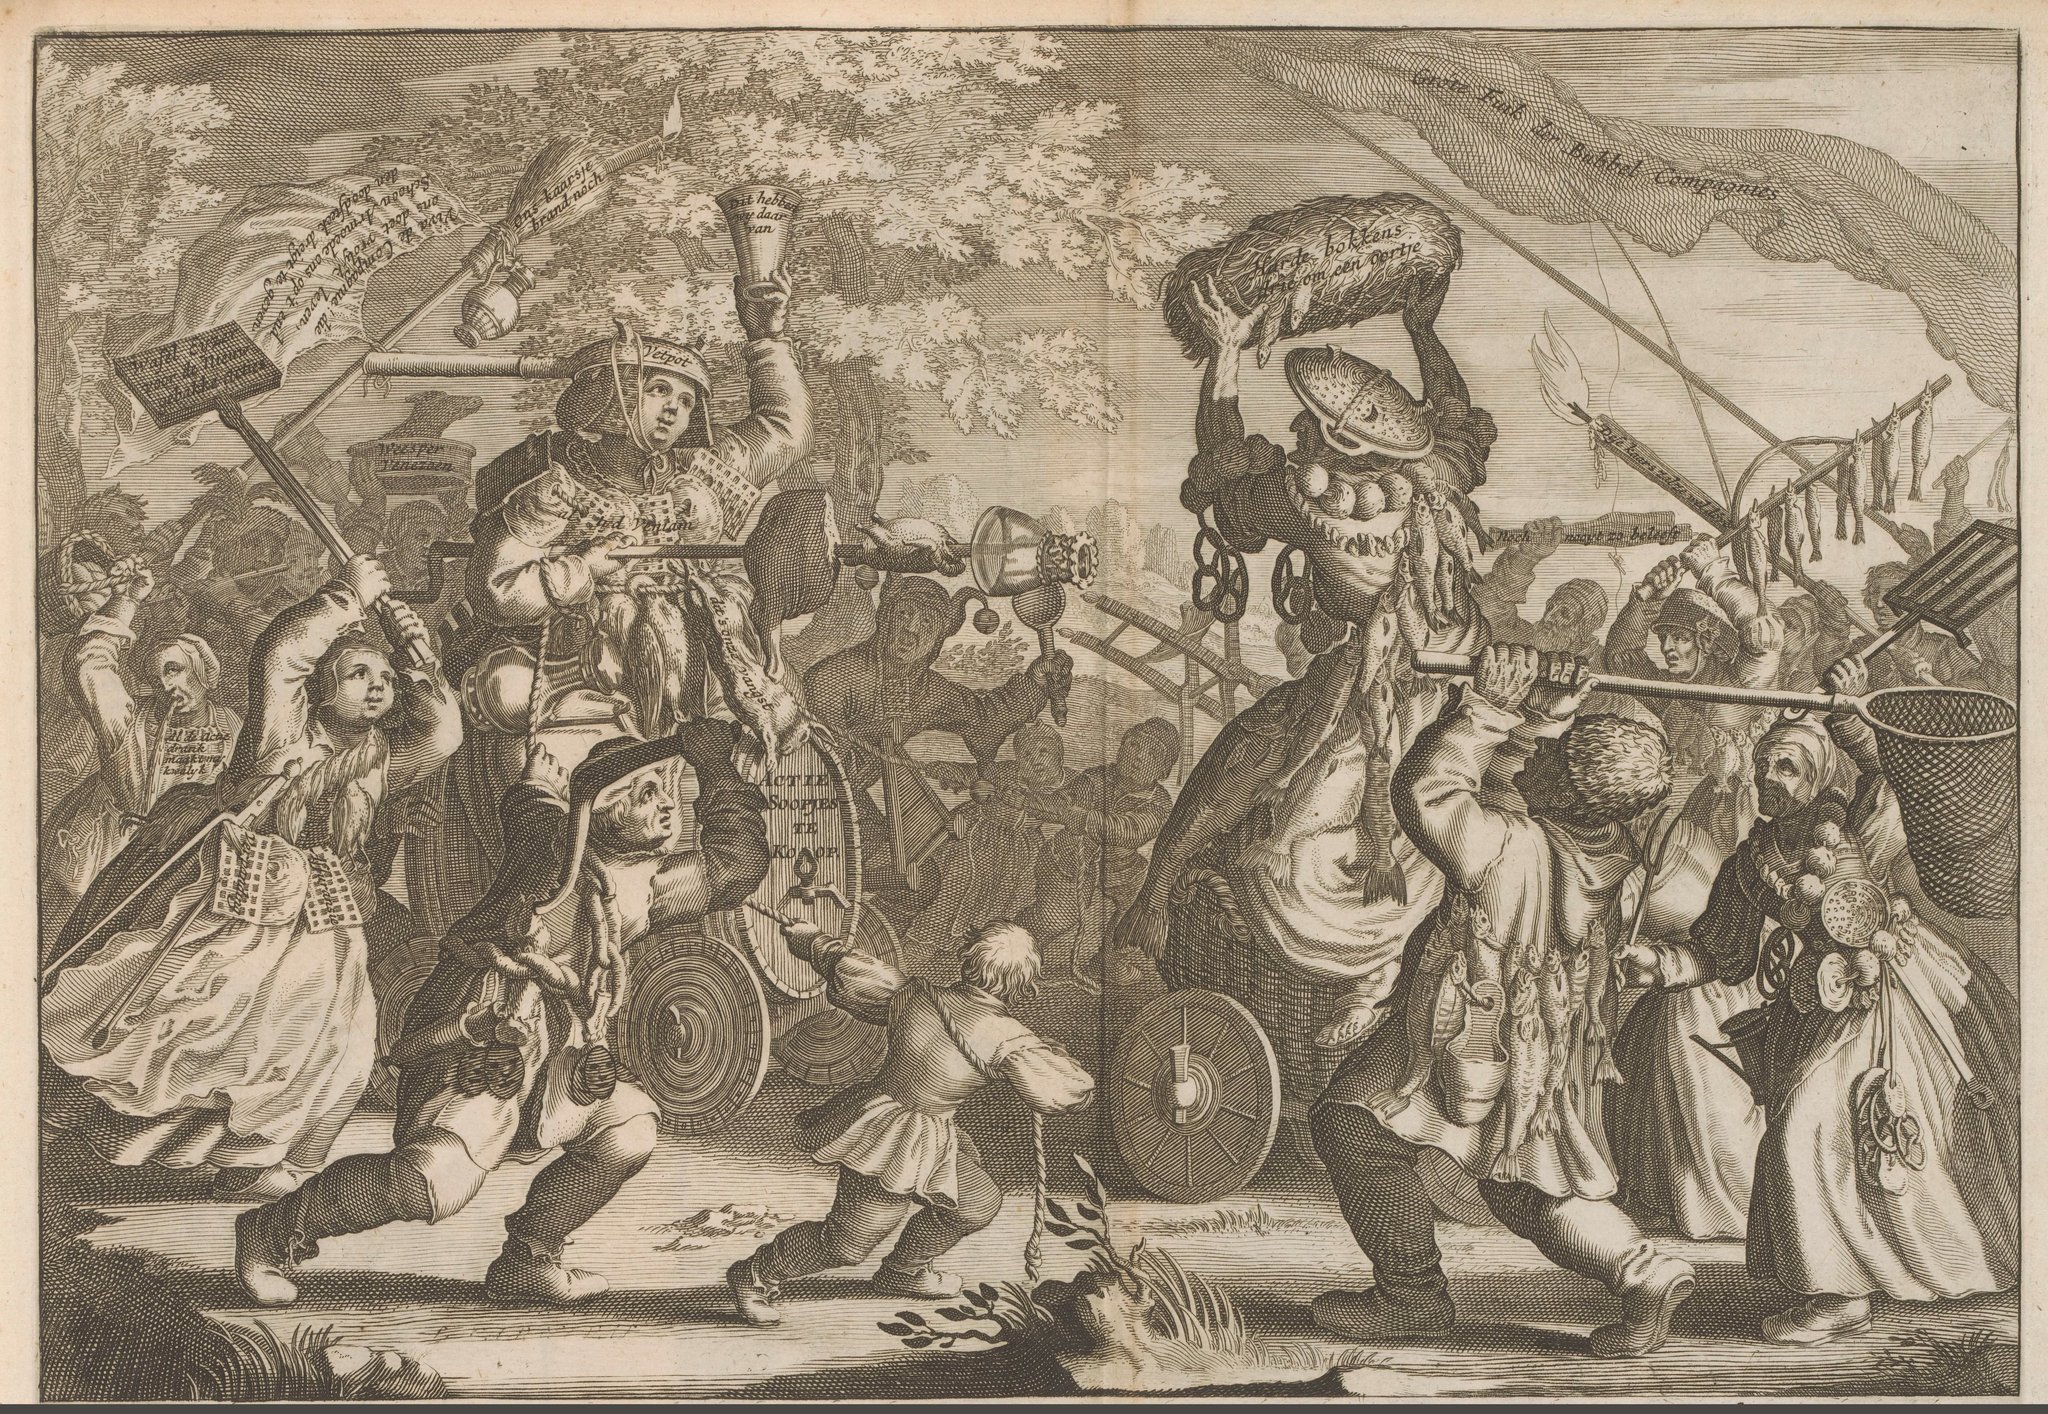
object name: cartoon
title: Stryd tuszen de Smullende Bubbel Heeren, en de aanstaande Armoede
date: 1600-1633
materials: paper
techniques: engraving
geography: northern netherlands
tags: strife of lent and carnival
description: Spotprent met de strijd tussen Vastenavond en Vasten geplaatst in de context van de Windhandel van 1720. Strijd tussen twee personen op strijdwagens getrokken door kinderen. Links Vastenavond, aangekleed met keukeninstrumenten, wild en gevogelte, drinkglazen en kannen. Zij en haar aanhangers dragen verwijzingen naar de actiehandel. Rechts Vasten, aangekleed met vissen en krakelingen, verwijst naar de aanstaande armoede. In het onderschrift een vers in vijf kolommen, gedrukt van een aparte plaat. Prent in de gebonden eerste uitgave (304 B 10) van Het Groote Tafereel der Dwaasheid met spotprenten op de Windhandel of Actiehandel van 1720.